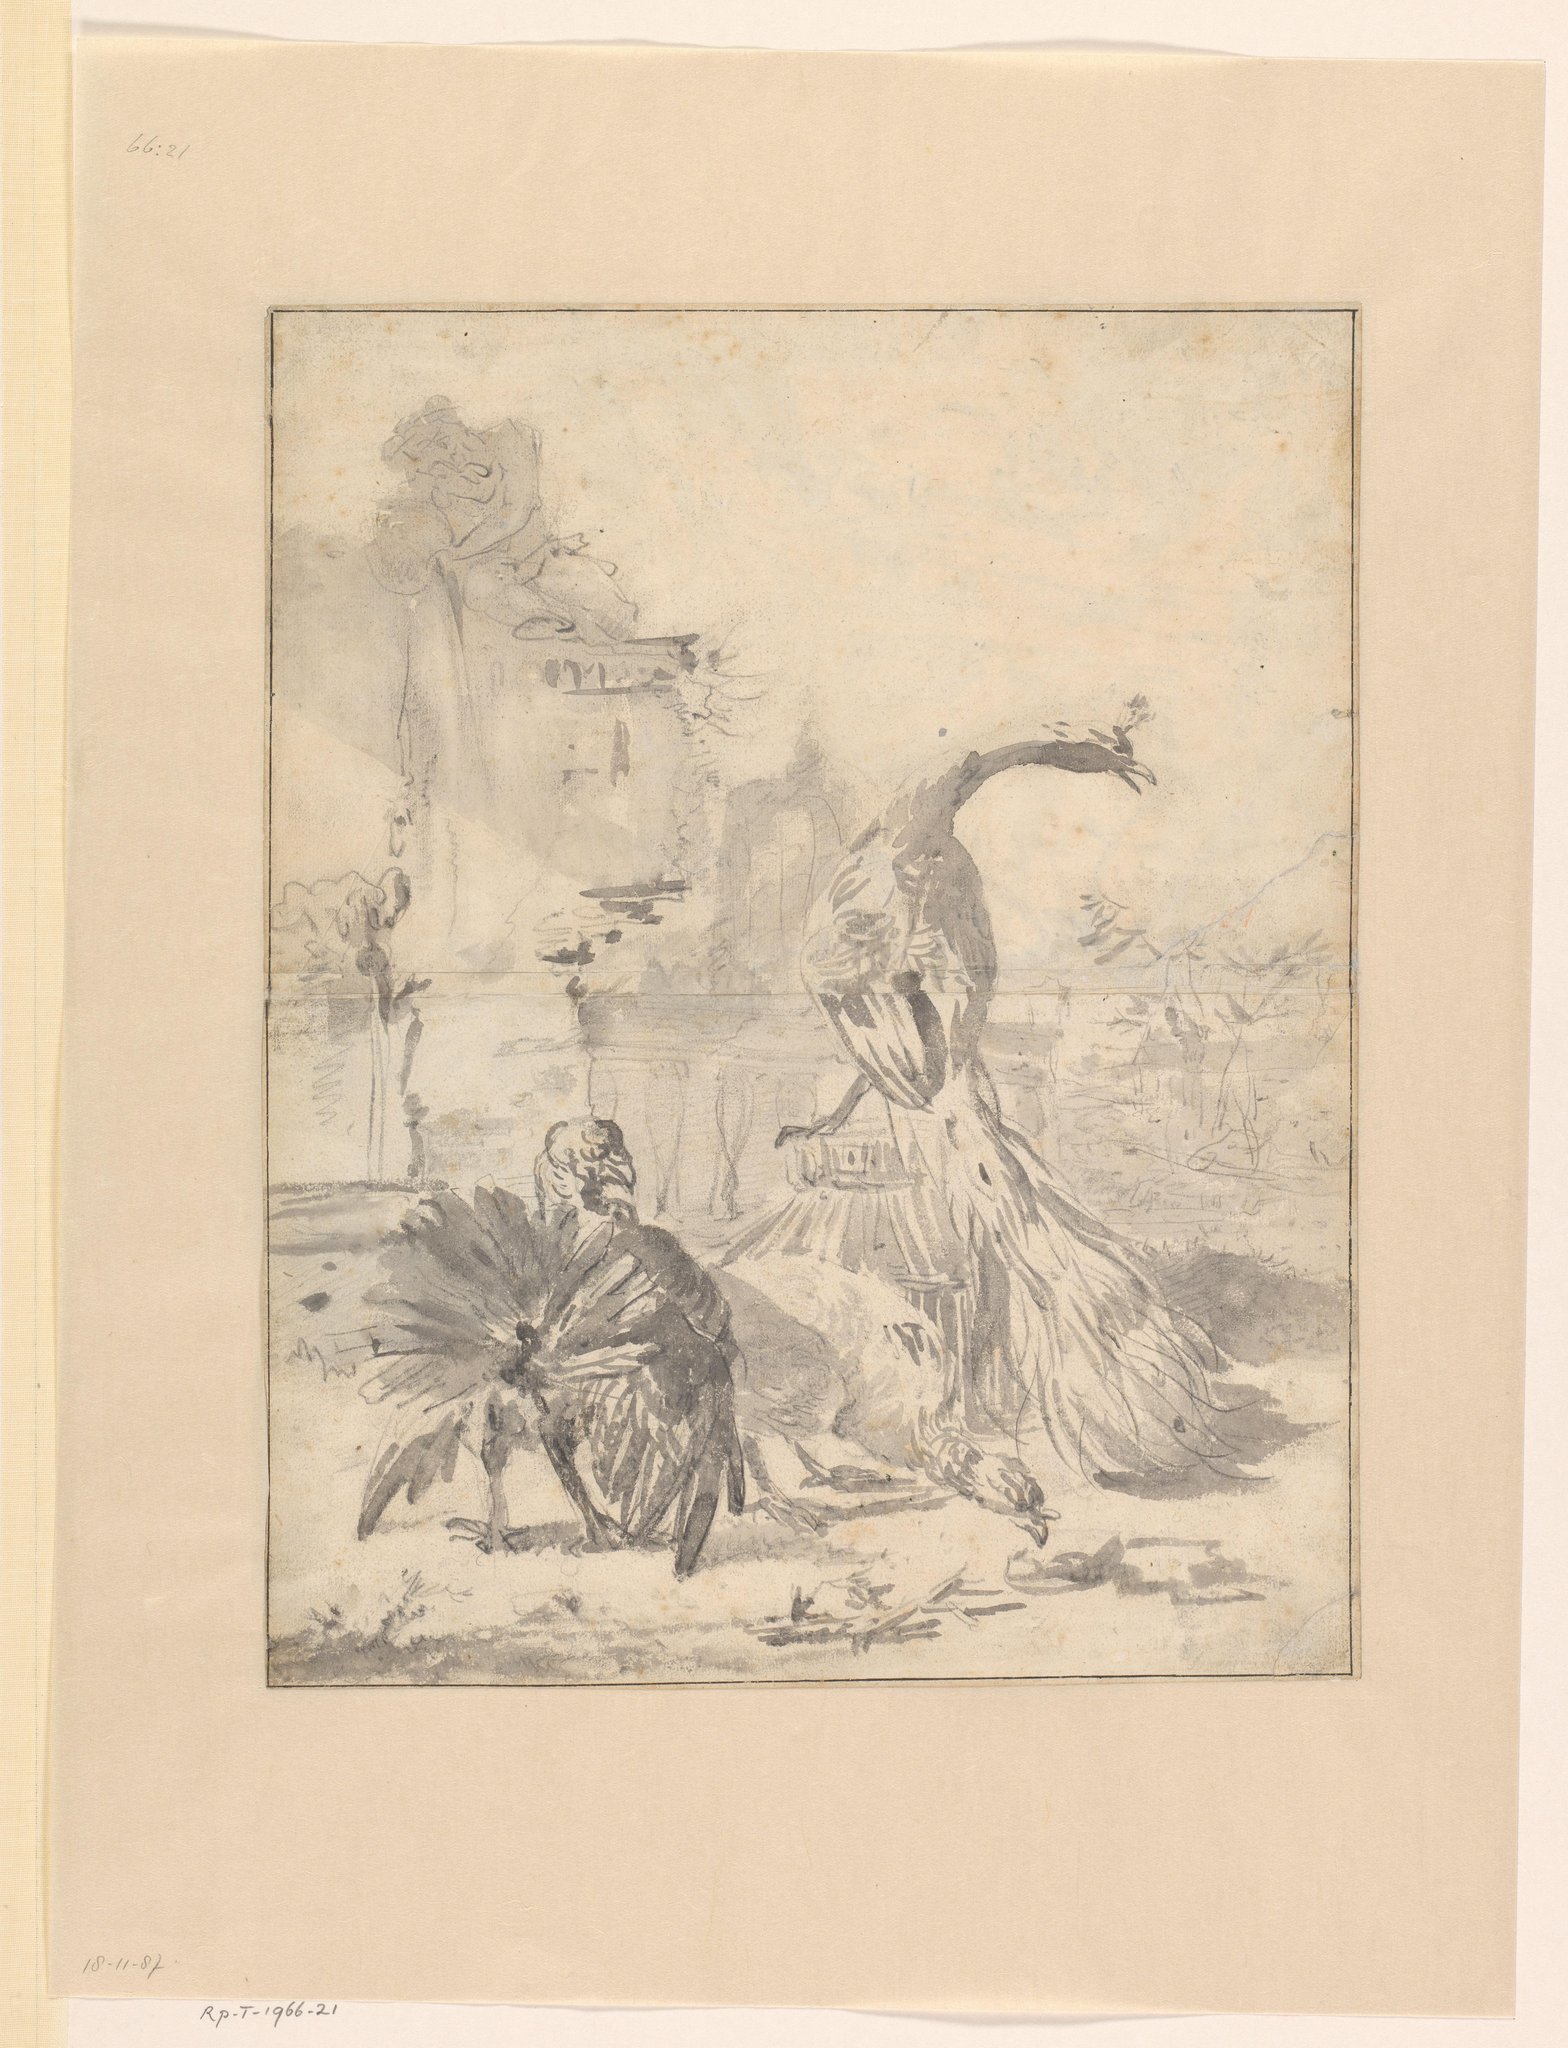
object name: drawing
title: Hoenderhof met een pauw en twee kalkoenen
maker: jan weenix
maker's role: draughtsman, painter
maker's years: 1640-1719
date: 1650-1719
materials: chalk, paper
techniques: brush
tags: ornamental birds: peacock, walker and runner birds: turkey